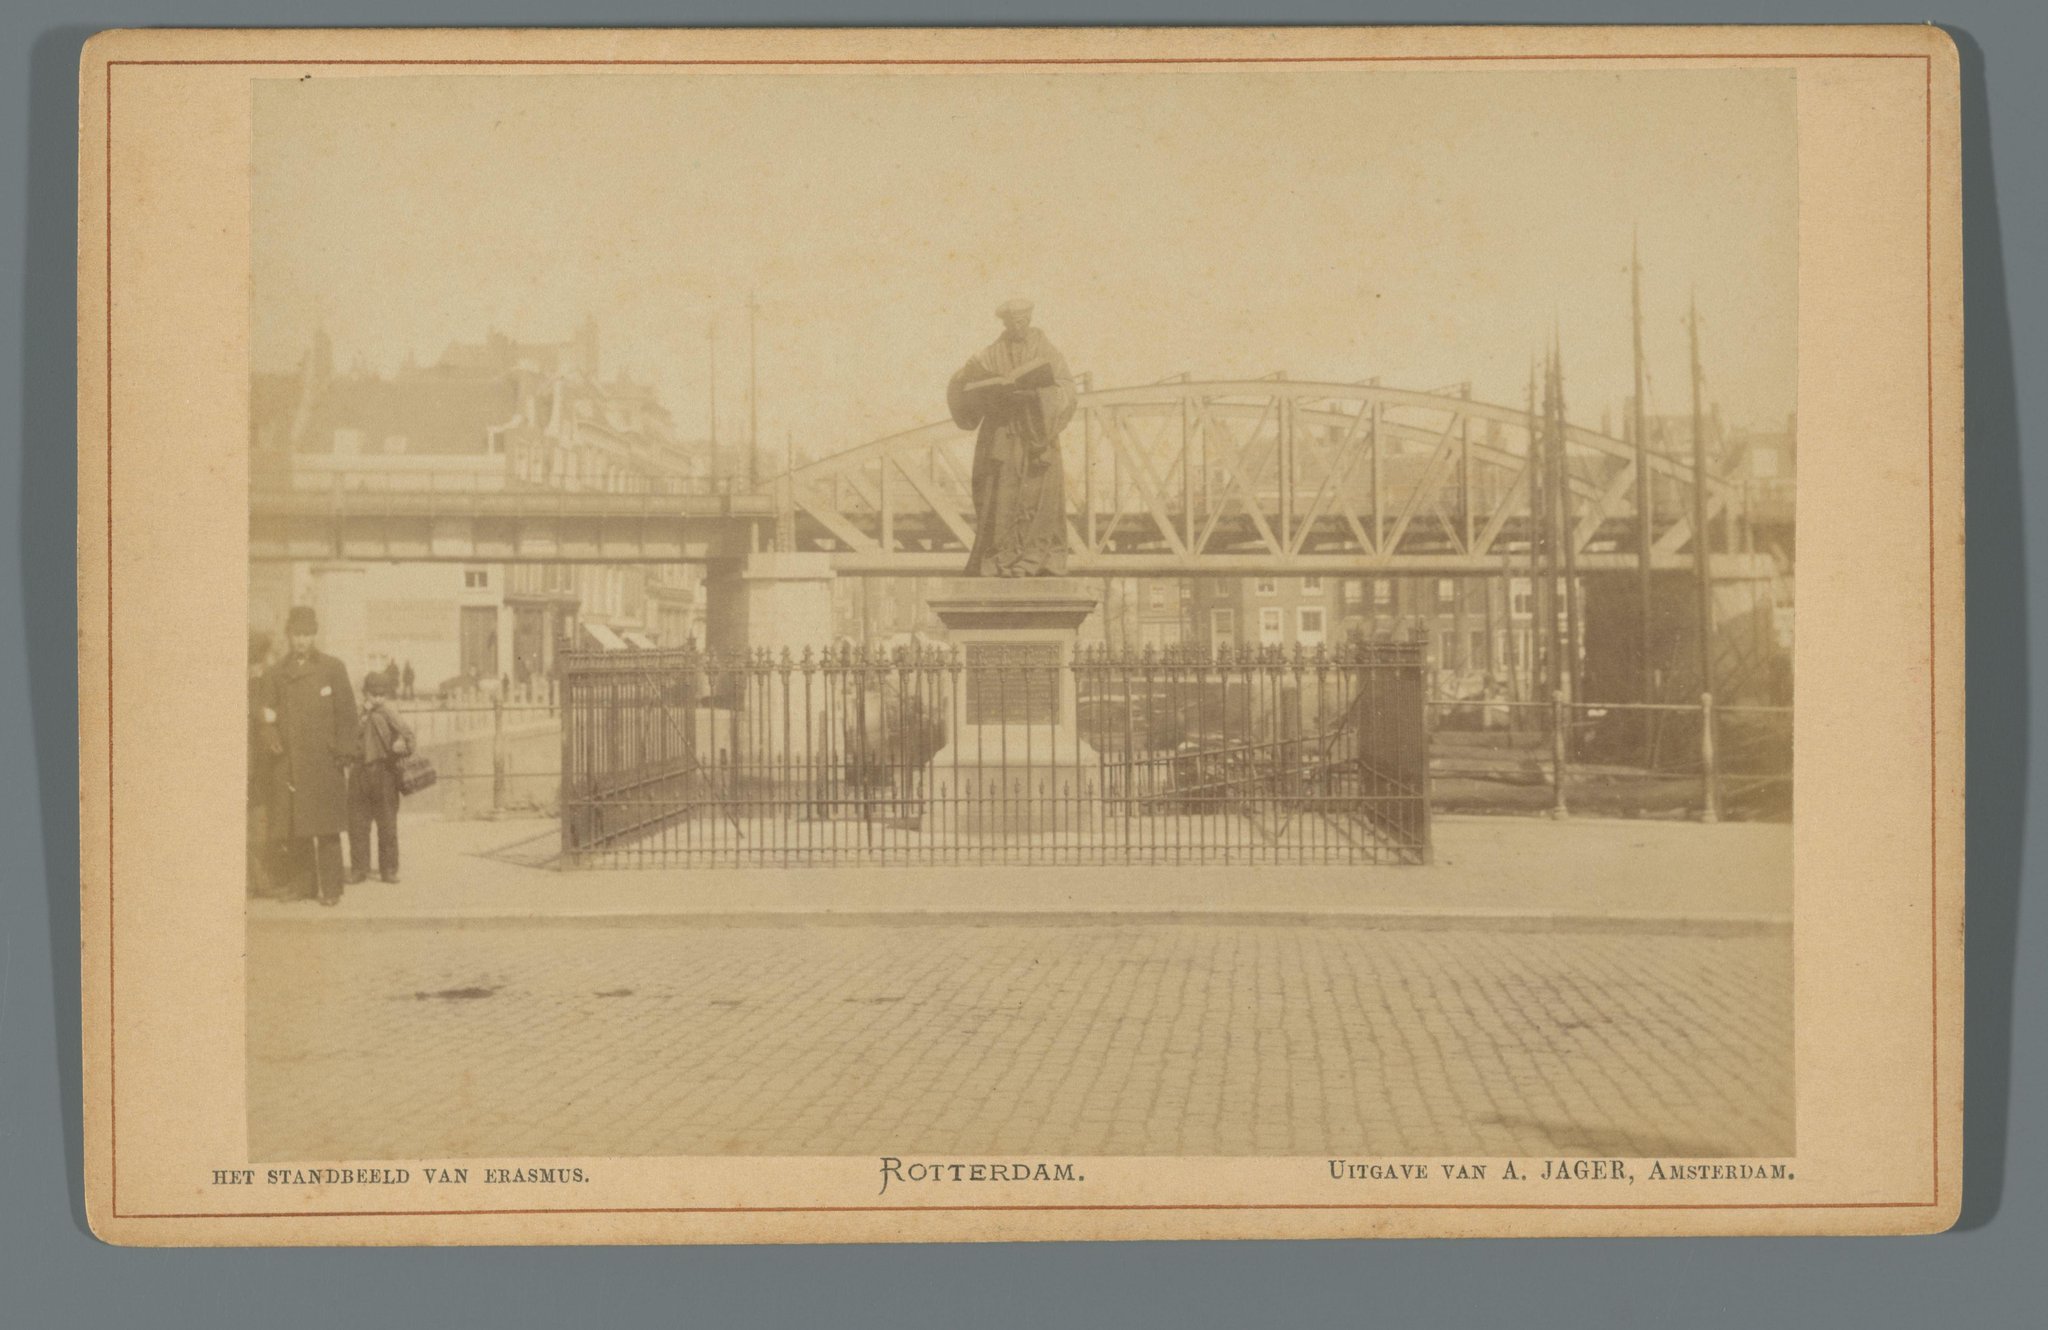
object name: cabinet photograph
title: Rotterdam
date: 1860-1890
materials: cardboard, photographic support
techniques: albumen print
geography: rotterdam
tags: rotterdam, desiderius erasmus, monument, statue